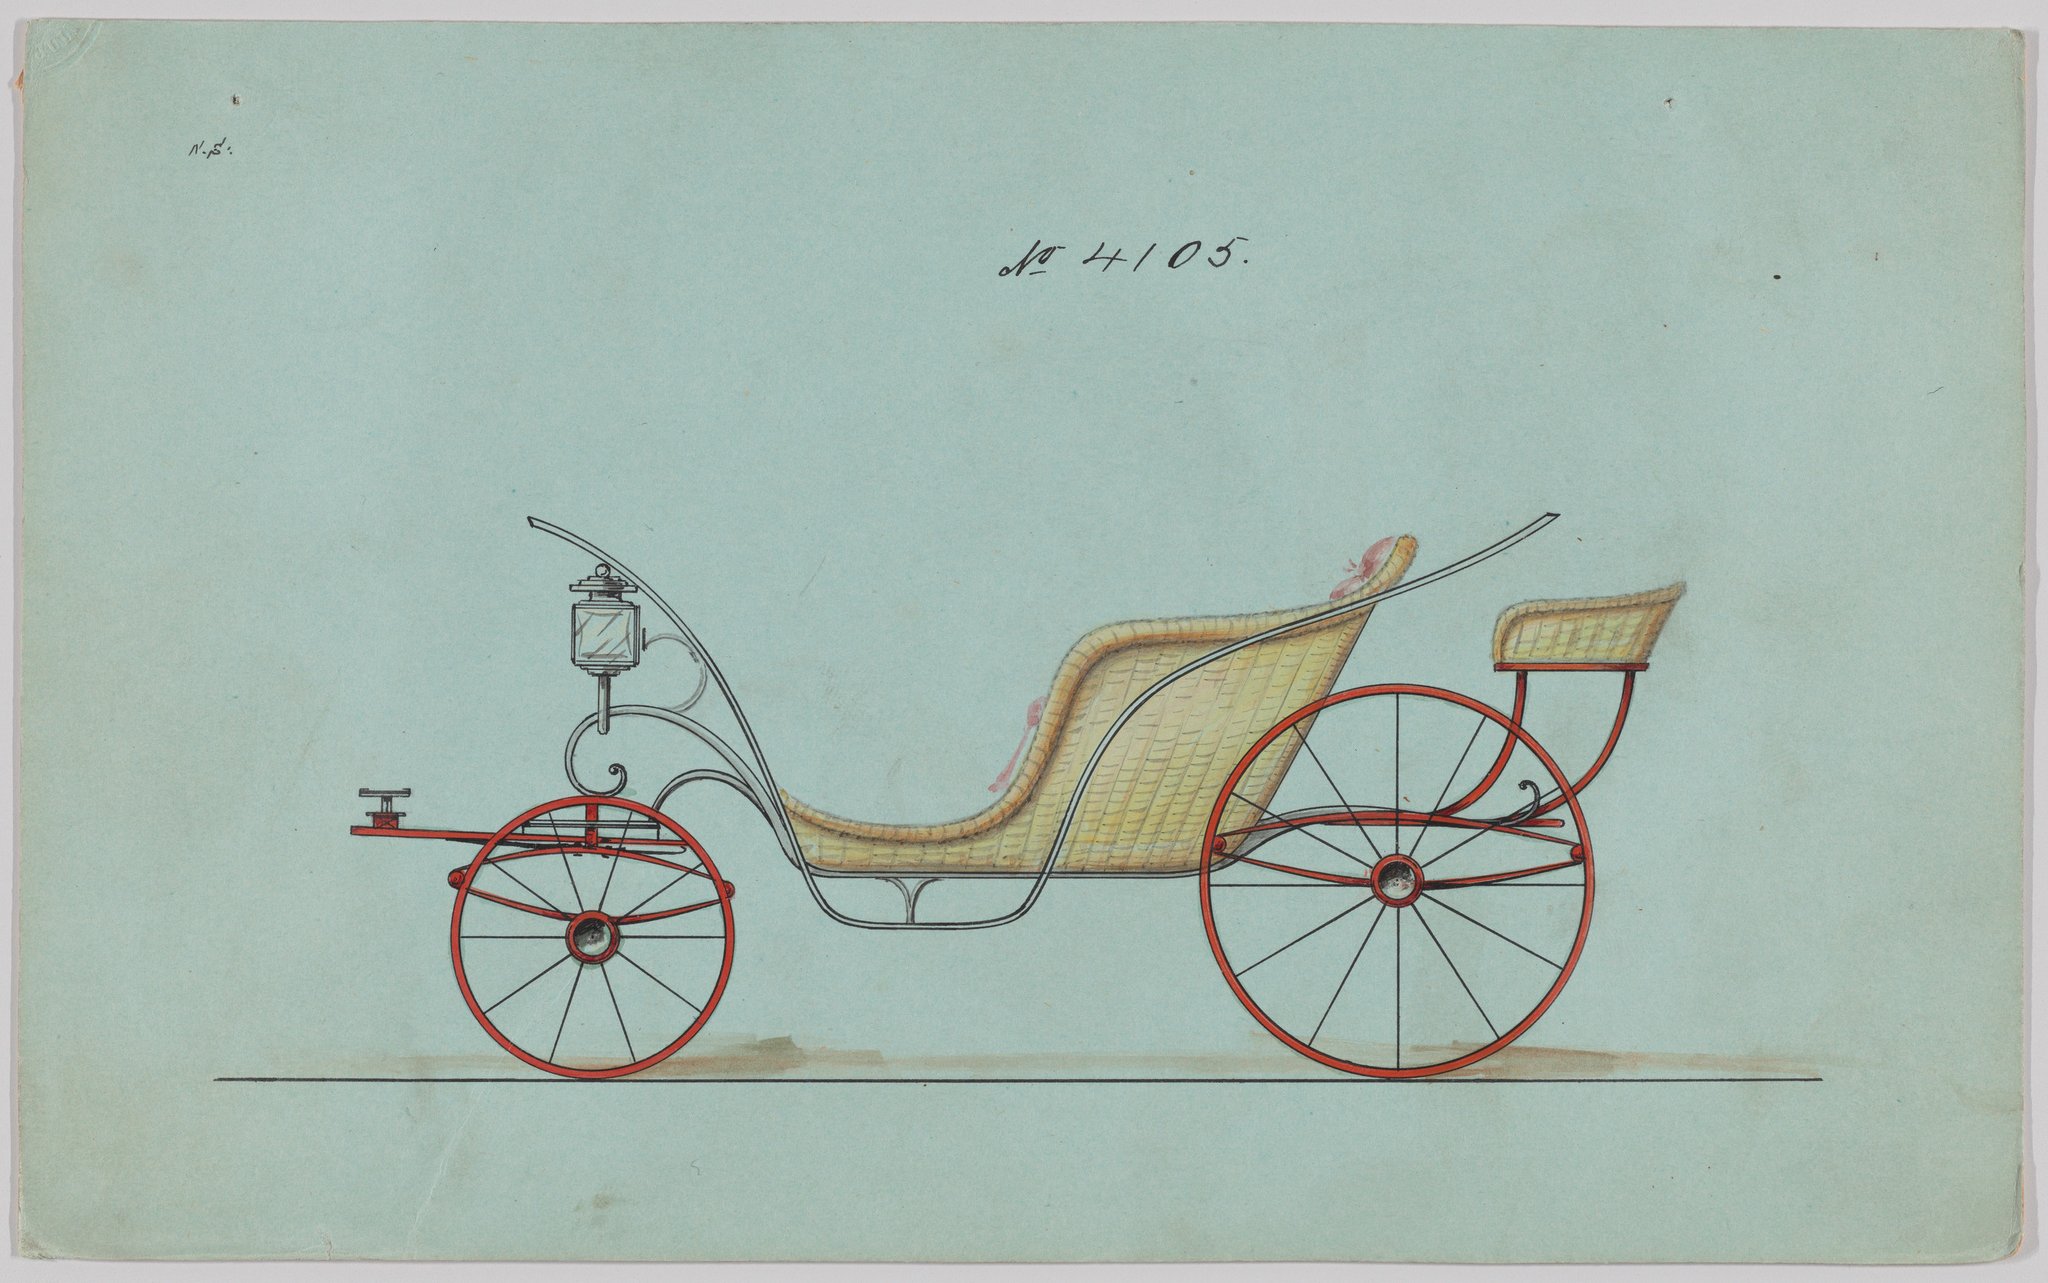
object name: drawing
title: Design for Pony Phaeton, no. 4105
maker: brewster & co.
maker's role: manufacturer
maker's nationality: american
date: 1890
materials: gouache, gum arabic, ink, watercolor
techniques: pen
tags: carriages